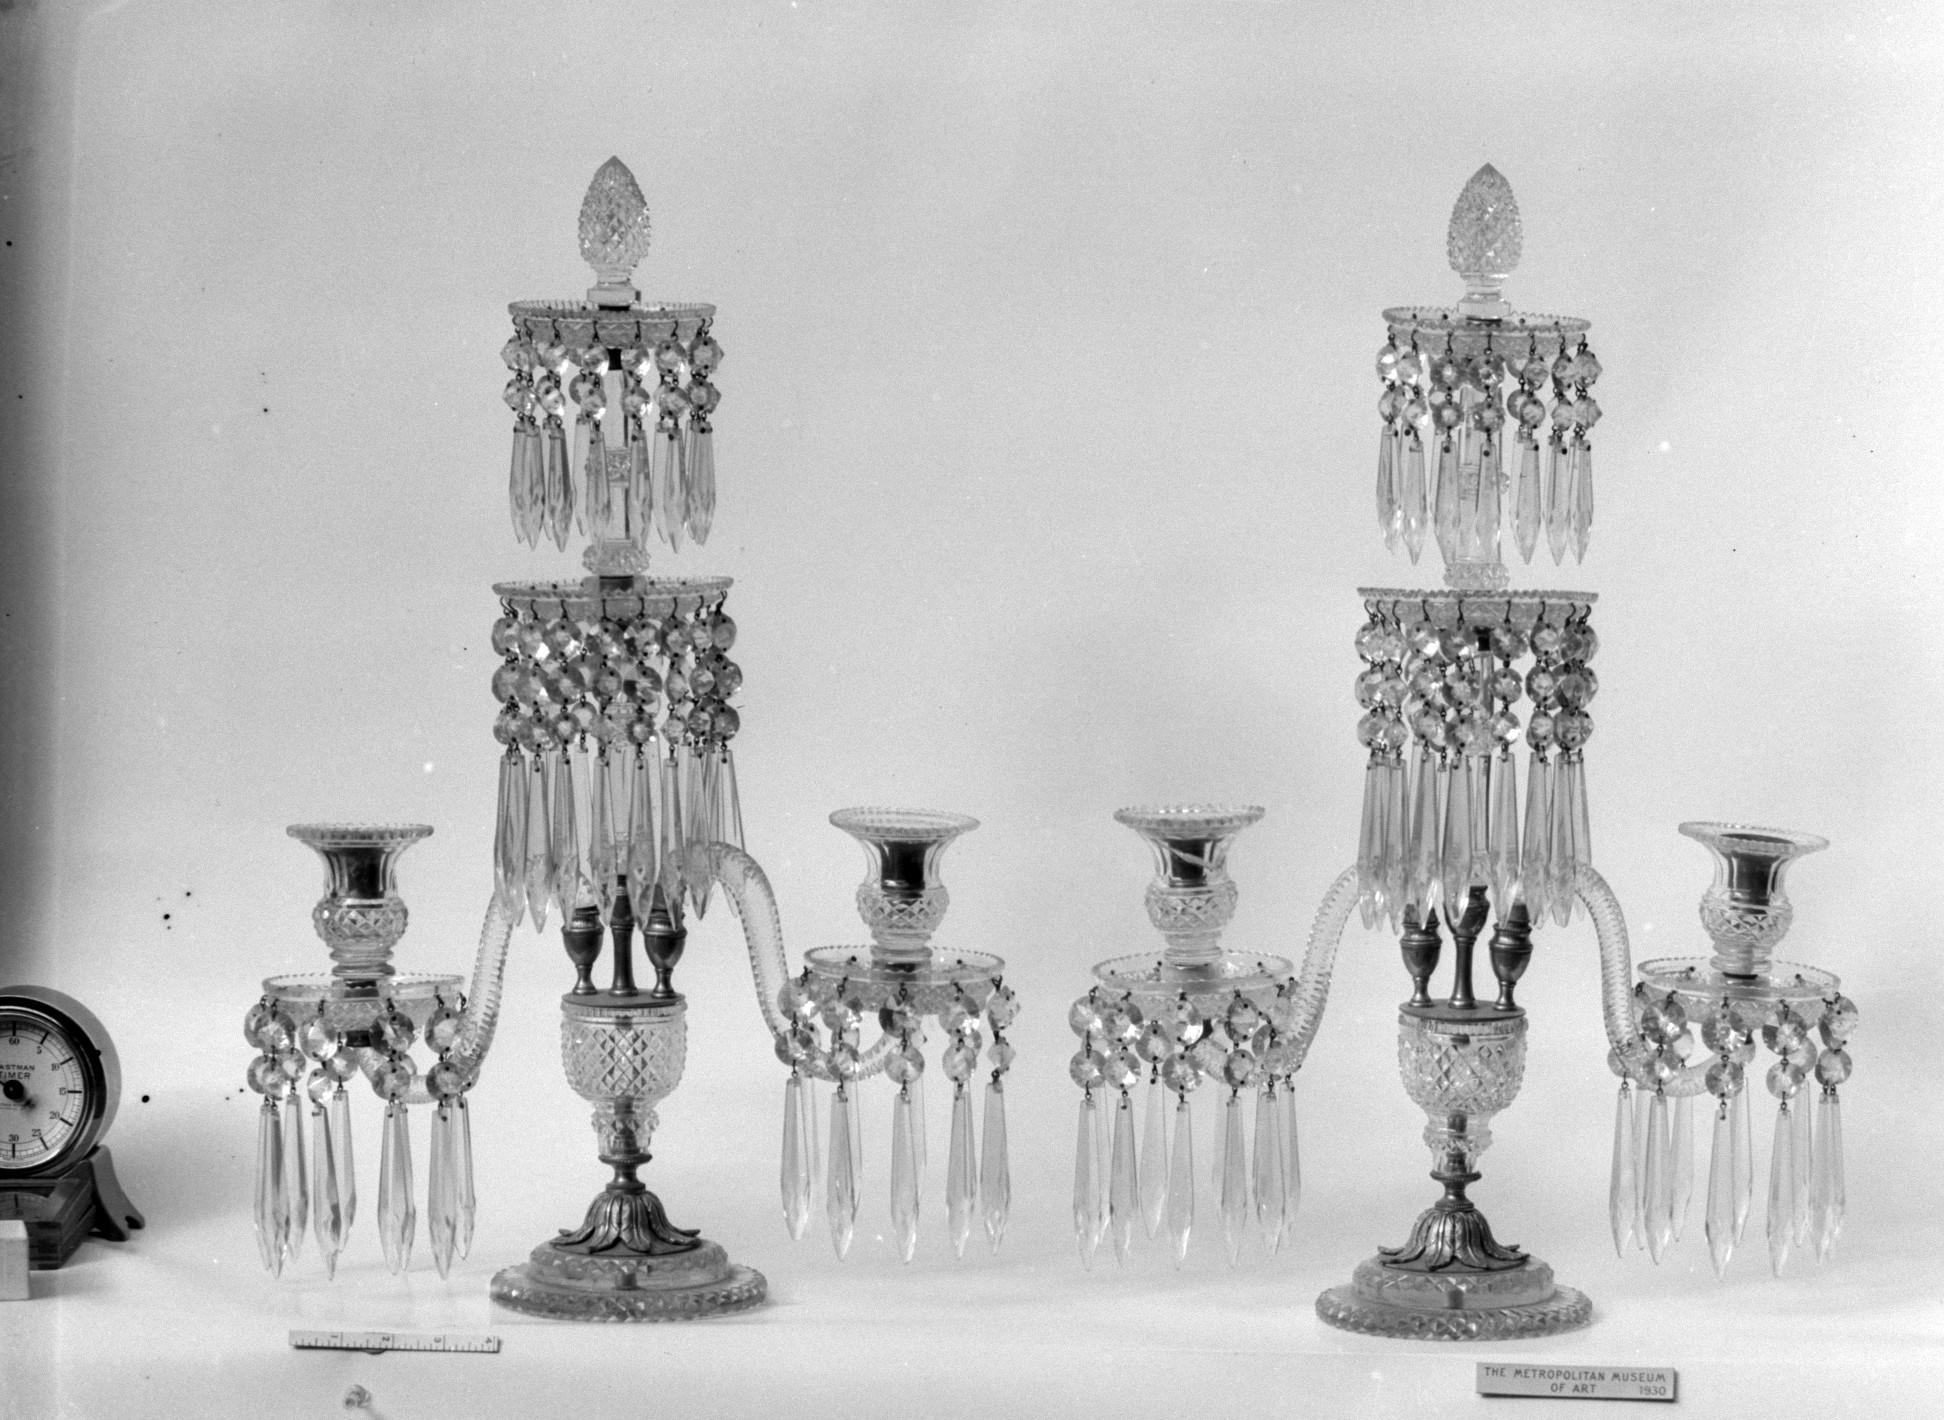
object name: candelabrum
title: Candelabrum (one of a pair)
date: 1800-1850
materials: gilt bronze, glass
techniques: glassblowing, cutting